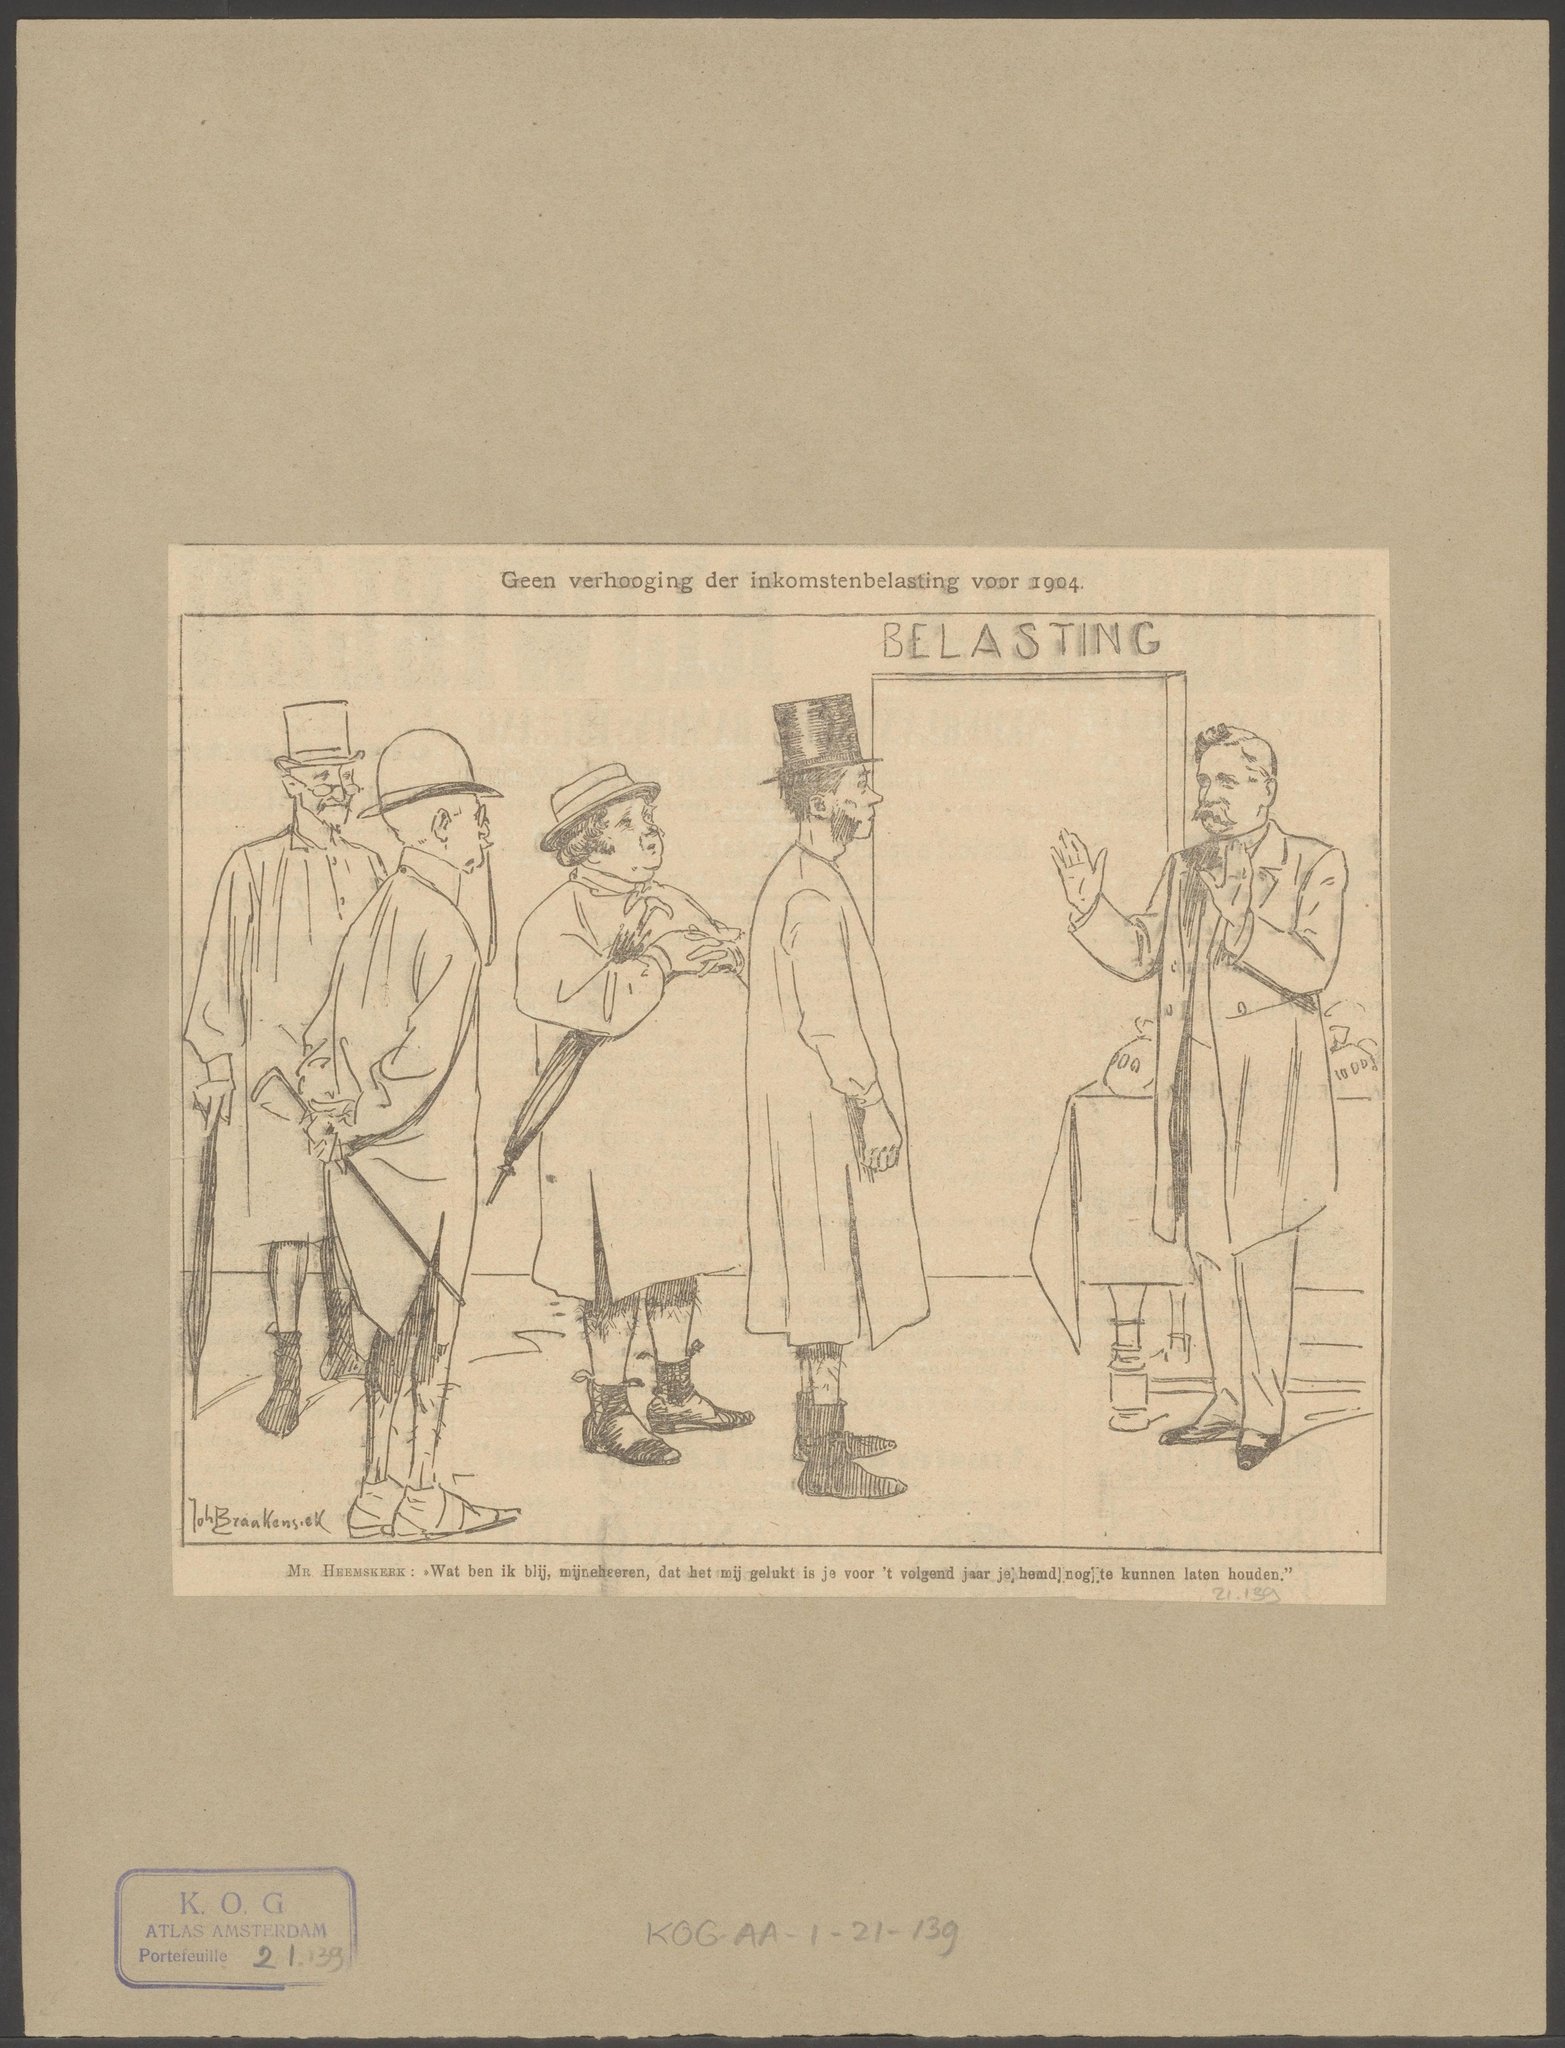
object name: cartoon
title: Geen verhooging der inkomstenbelasting voor 1904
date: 1903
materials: paper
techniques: letterpress printing, line block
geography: netherlands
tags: amsterdam, utrecht, underclothes, tax payment, underclothes and nightwear, municipal government, political caricatures and satires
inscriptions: collector's mark: Lugt 1641b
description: Prent uit: De Amsterdammer. Weekblad voor Nederland (1903), 30 augustus 1903, p. 11.